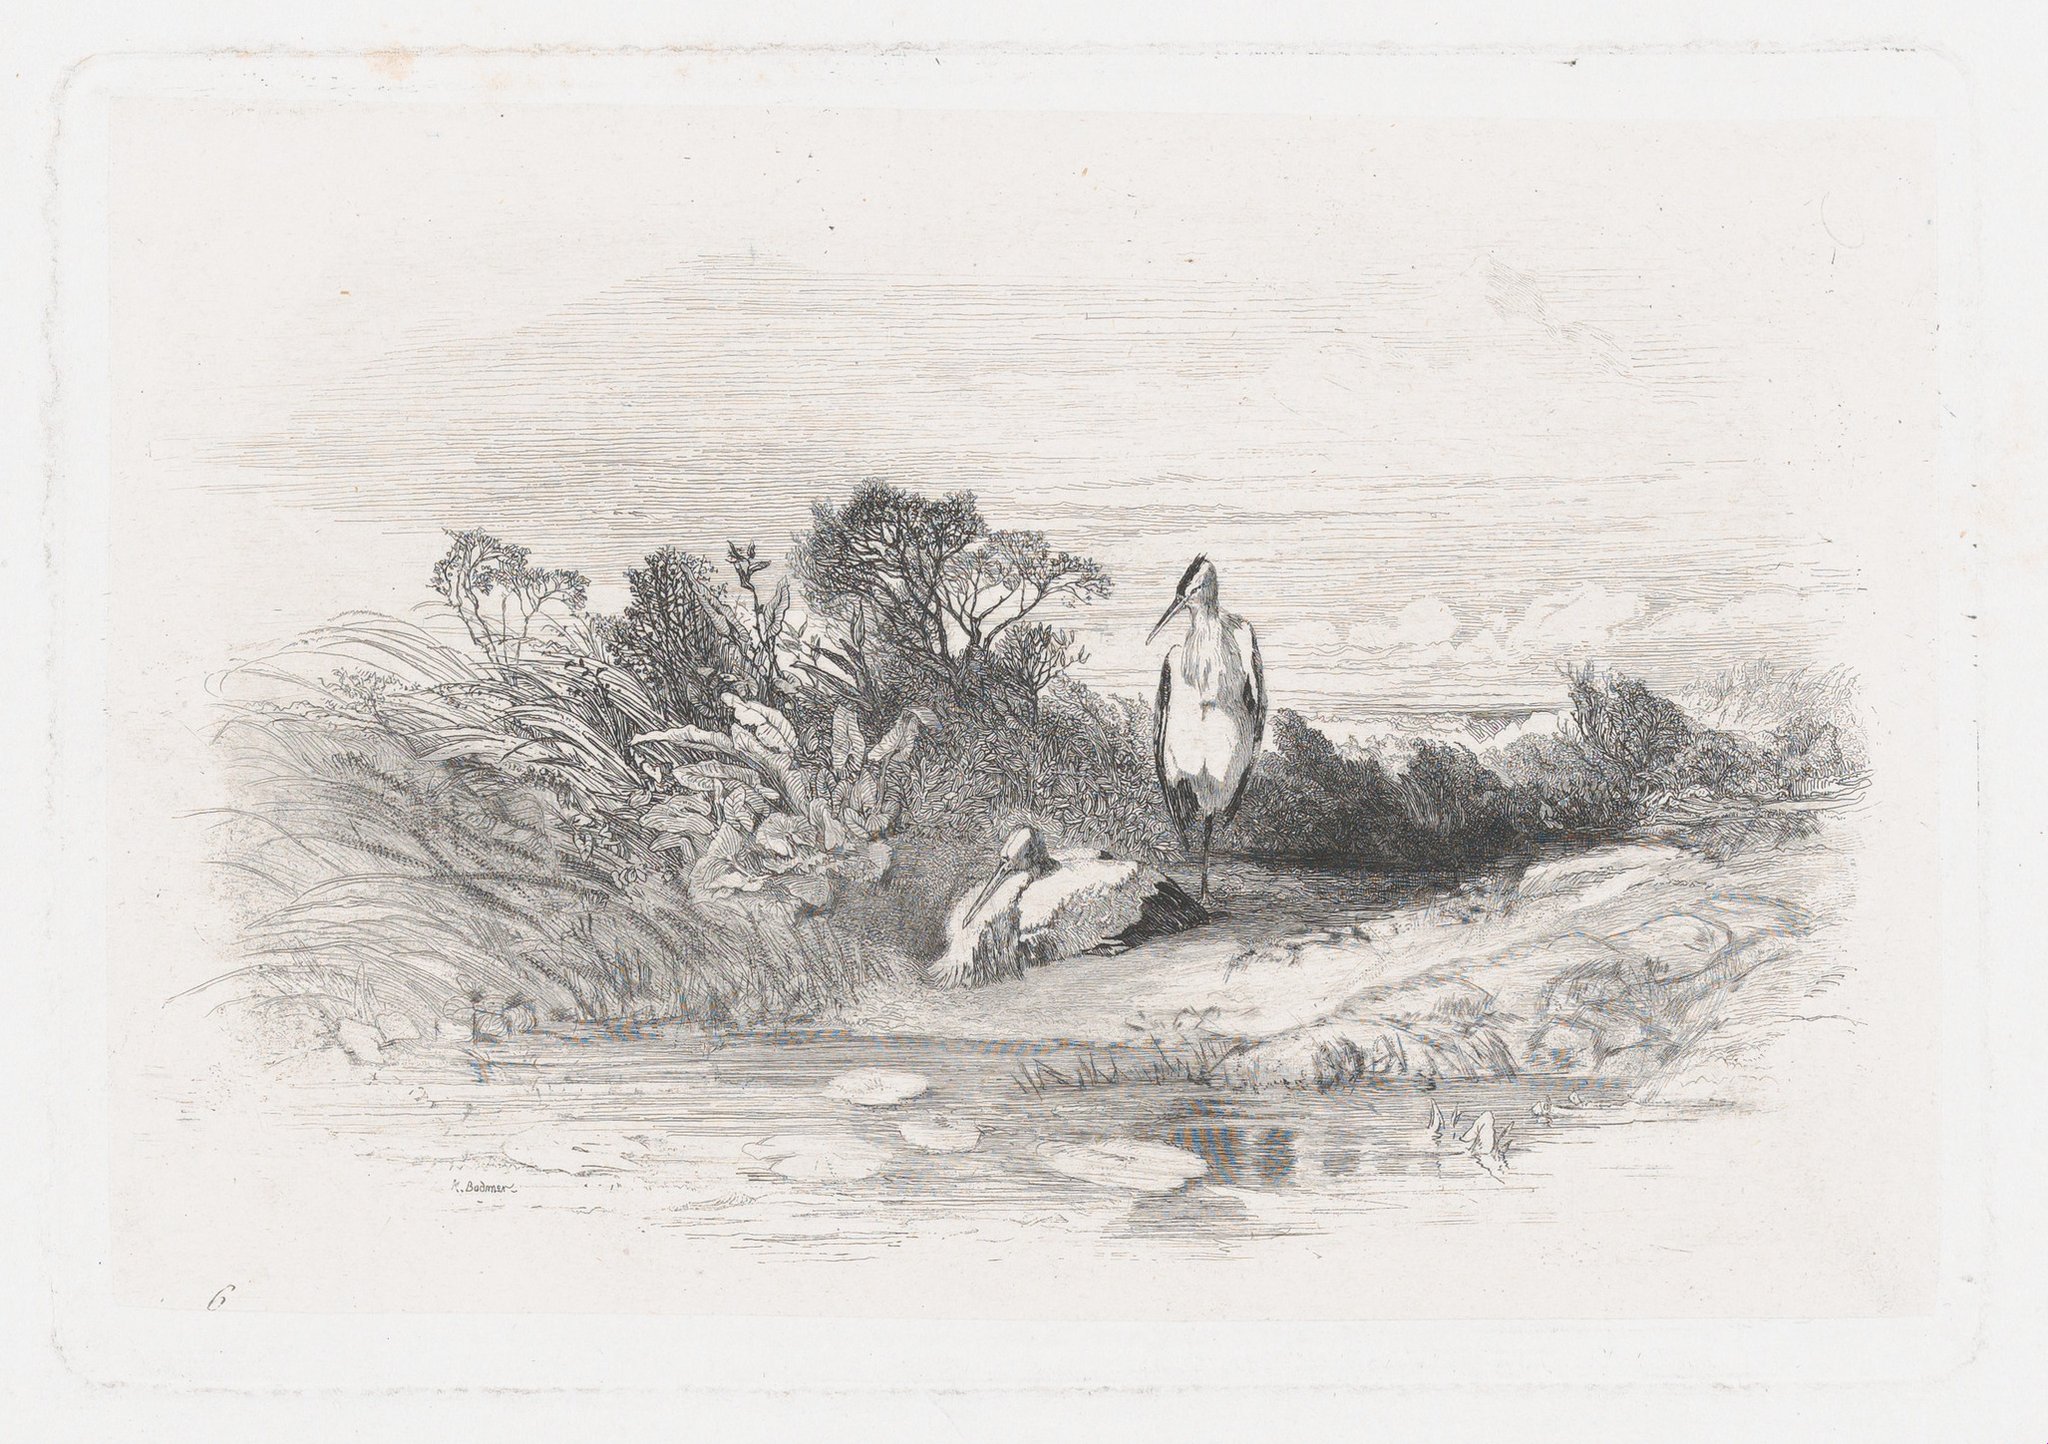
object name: print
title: Two Herons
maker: karl bodmer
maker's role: artist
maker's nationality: swiss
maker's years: 1809-1893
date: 1860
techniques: etching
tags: birds